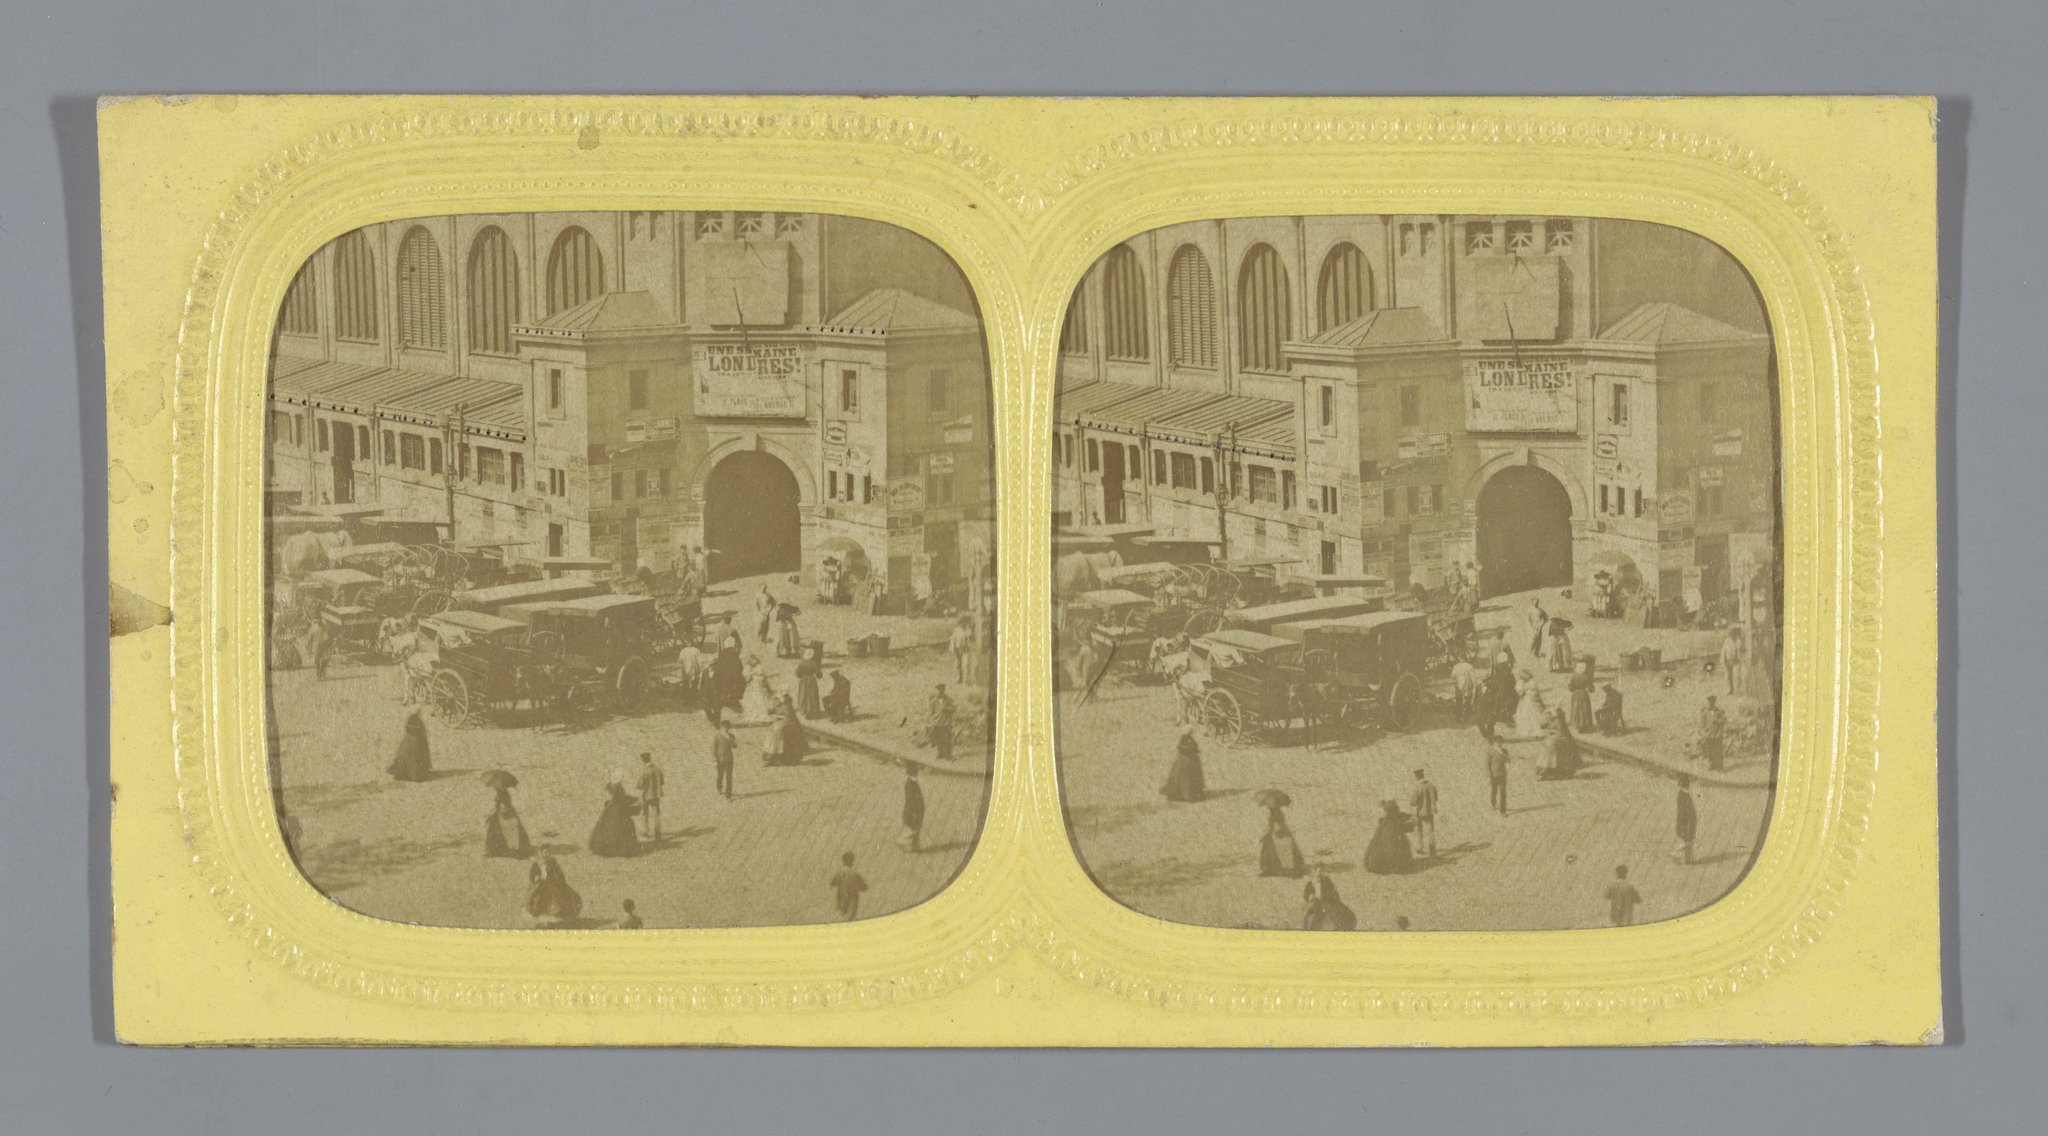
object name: tissue stereograph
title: Graanhal of de Halle aux blés in Parijs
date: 1858-1875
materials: cardboard, paper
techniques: albumen print, perforating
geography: paris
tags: market-hall